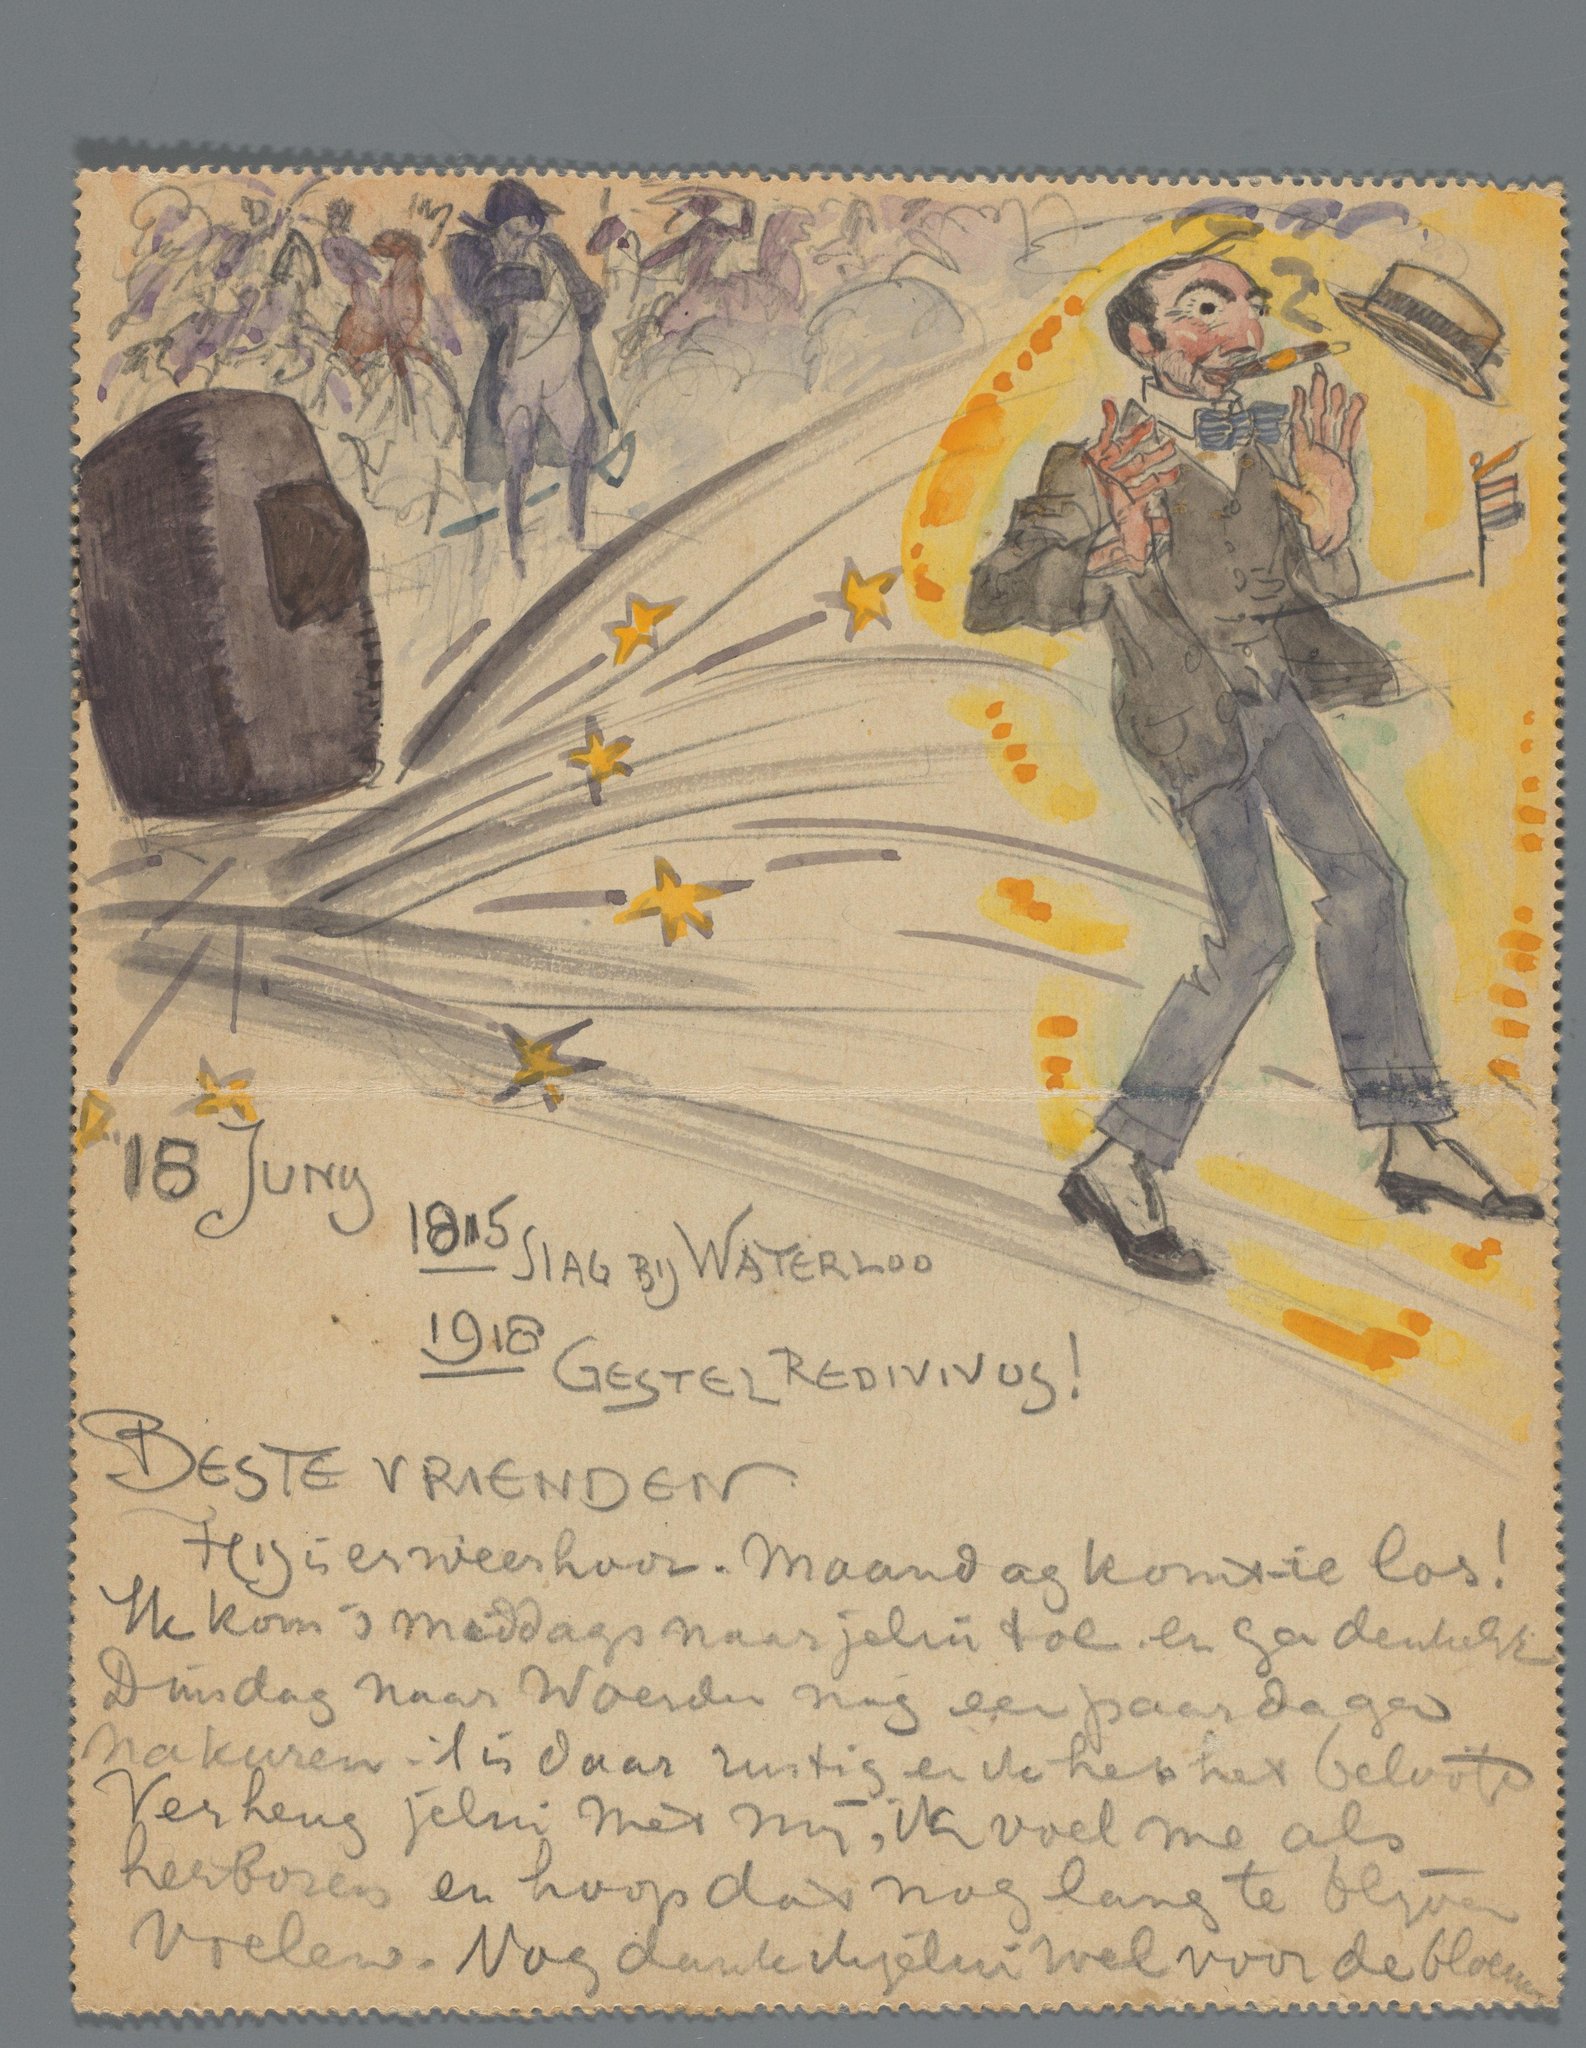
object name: letter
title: Brief aan Jan Ponstijn en Henriëtte Johanna Petronella van Hilten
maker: leo gestel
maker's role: draughtsman, print maker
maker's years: 1881-1941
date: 1918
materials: paper, pencil, watercolor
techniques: brush, writing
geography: amsterdam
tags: henriëtte johanna petronella ponstijn-van hilten, jan petrus ponstijn, print maker, draughtsman, leo gestel, portrait, self-portrait of artist, projectiles, explosives, etc., recovery, convalescence of sick person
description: Brief met een tekening van een ontploffende bom of granaat en een zelfportret van Leo Gestel met een sigaar in zijn mond omgeven door een cirkel van licht. Brief maakt deel uit van een album.